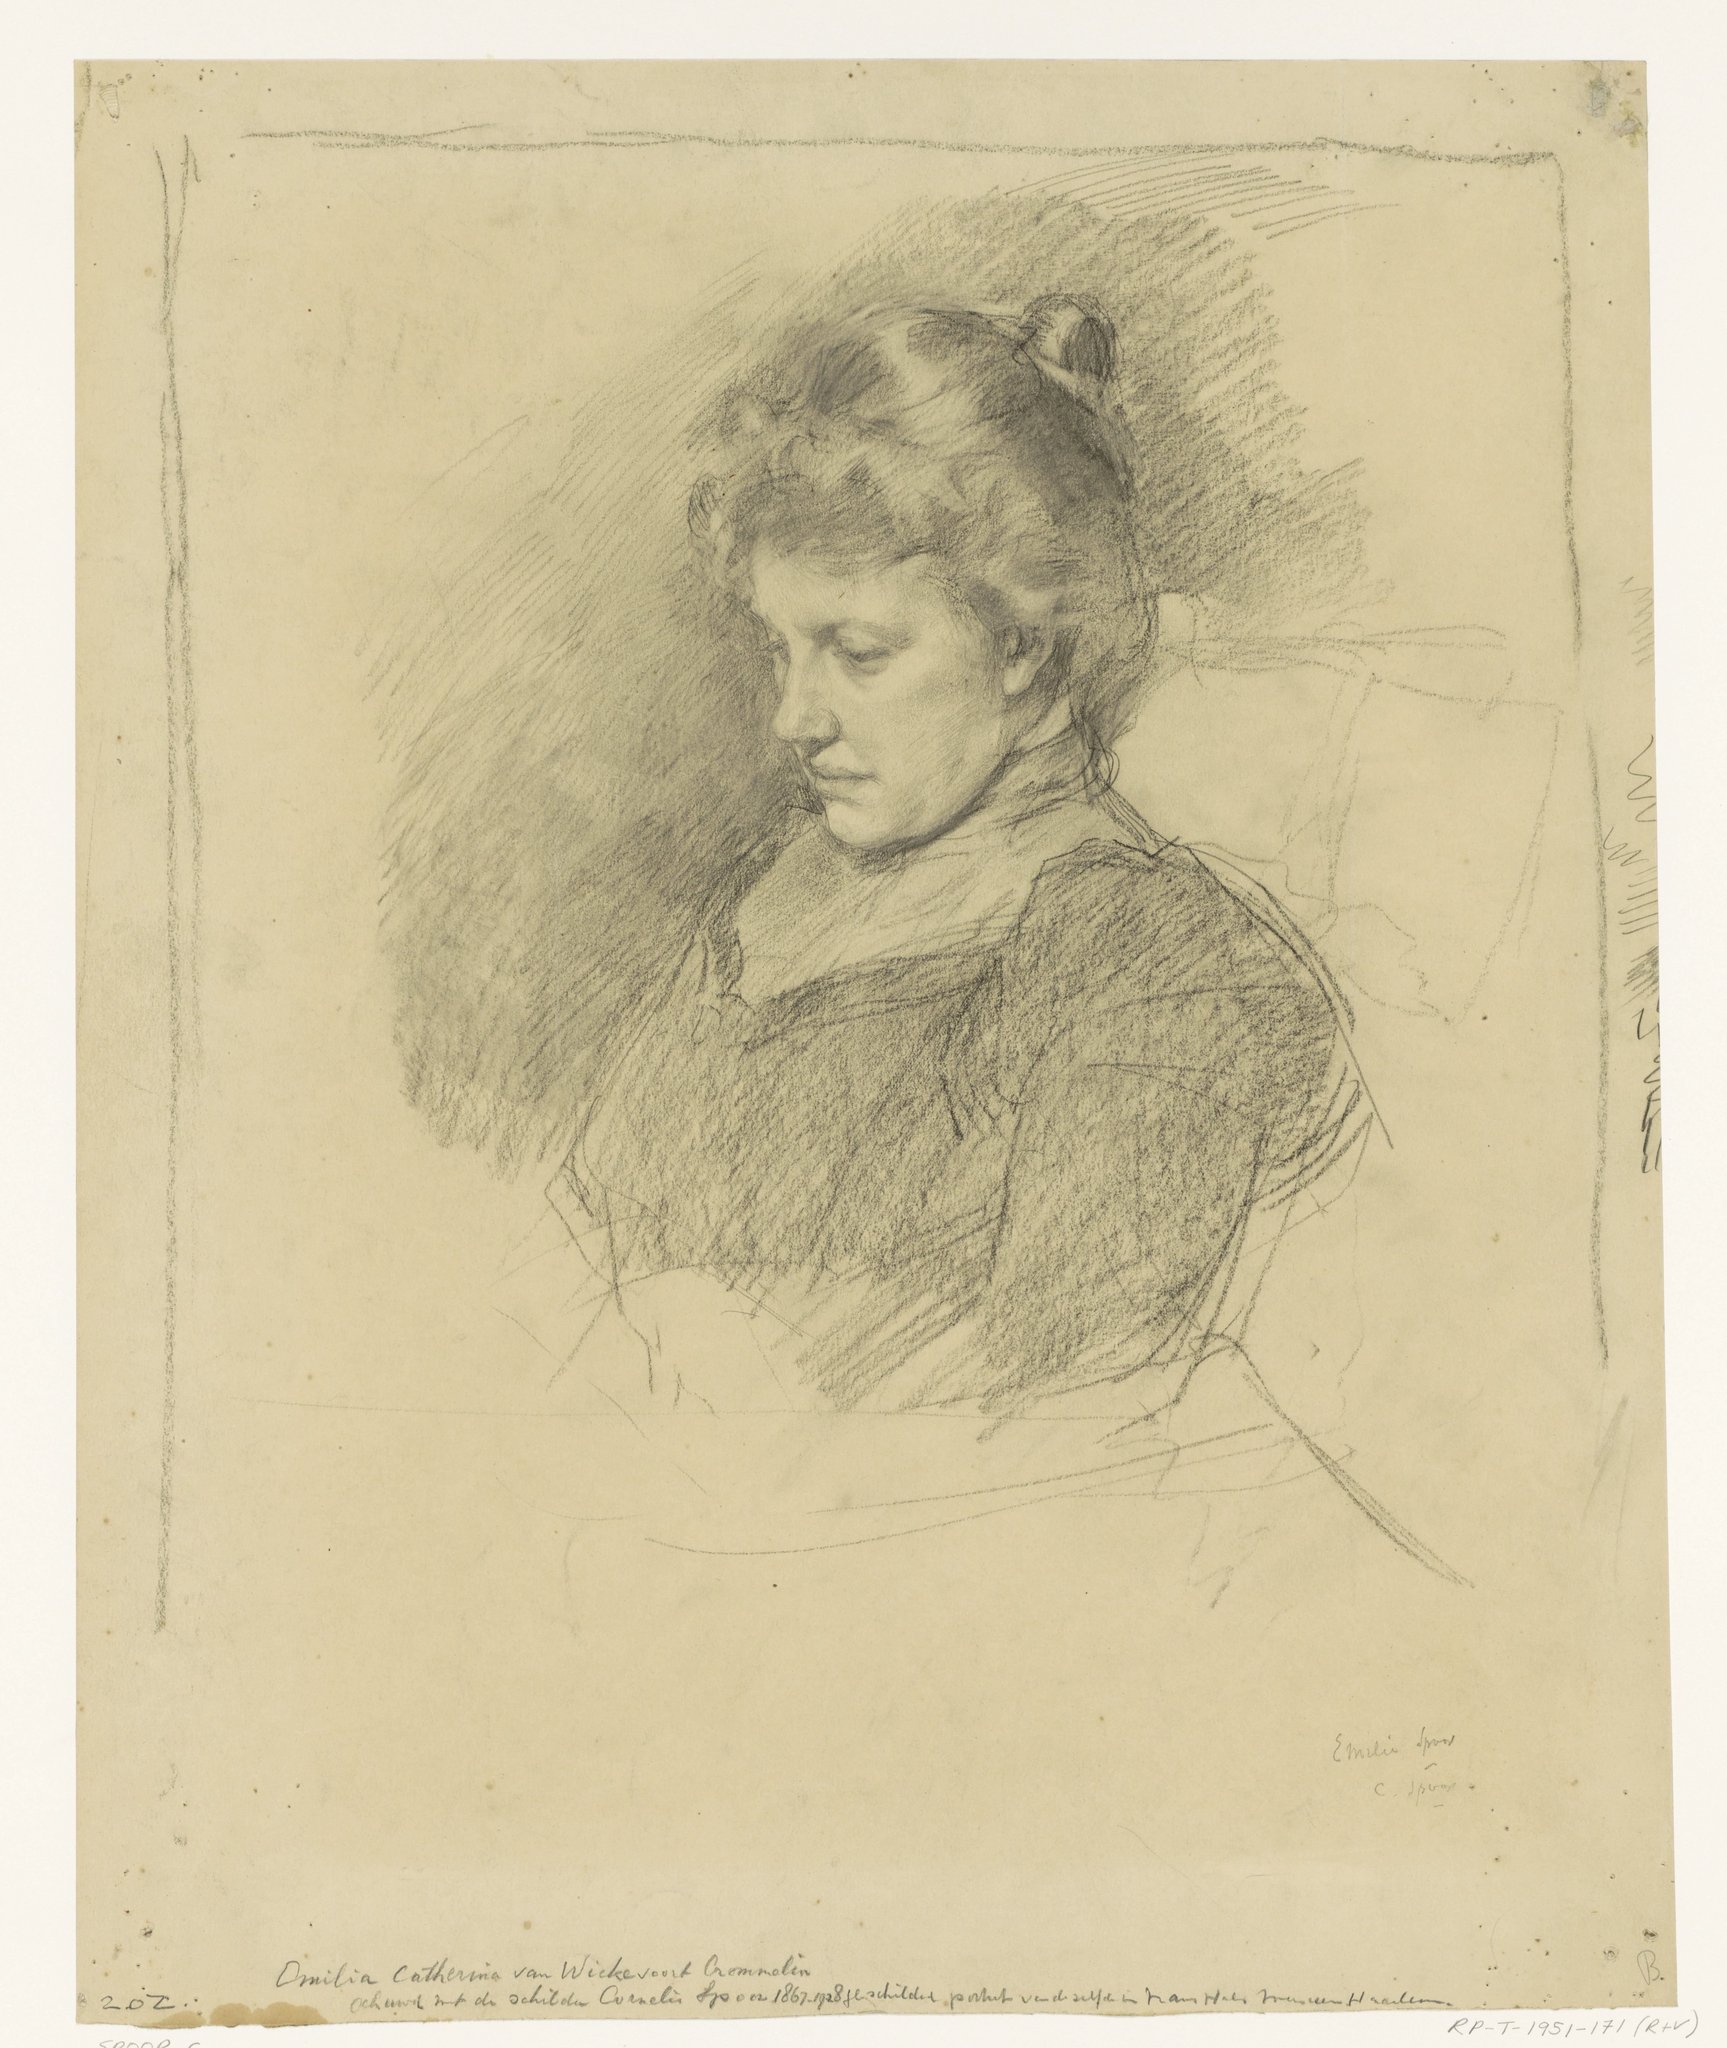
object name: drawing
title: Portret van Emilia Spoor-van Wickevoirt Crommelin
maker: cornelis spoor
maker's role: draughtsman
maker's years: 1867-1928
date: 1877-1928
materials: chalk, paper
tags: historical persons